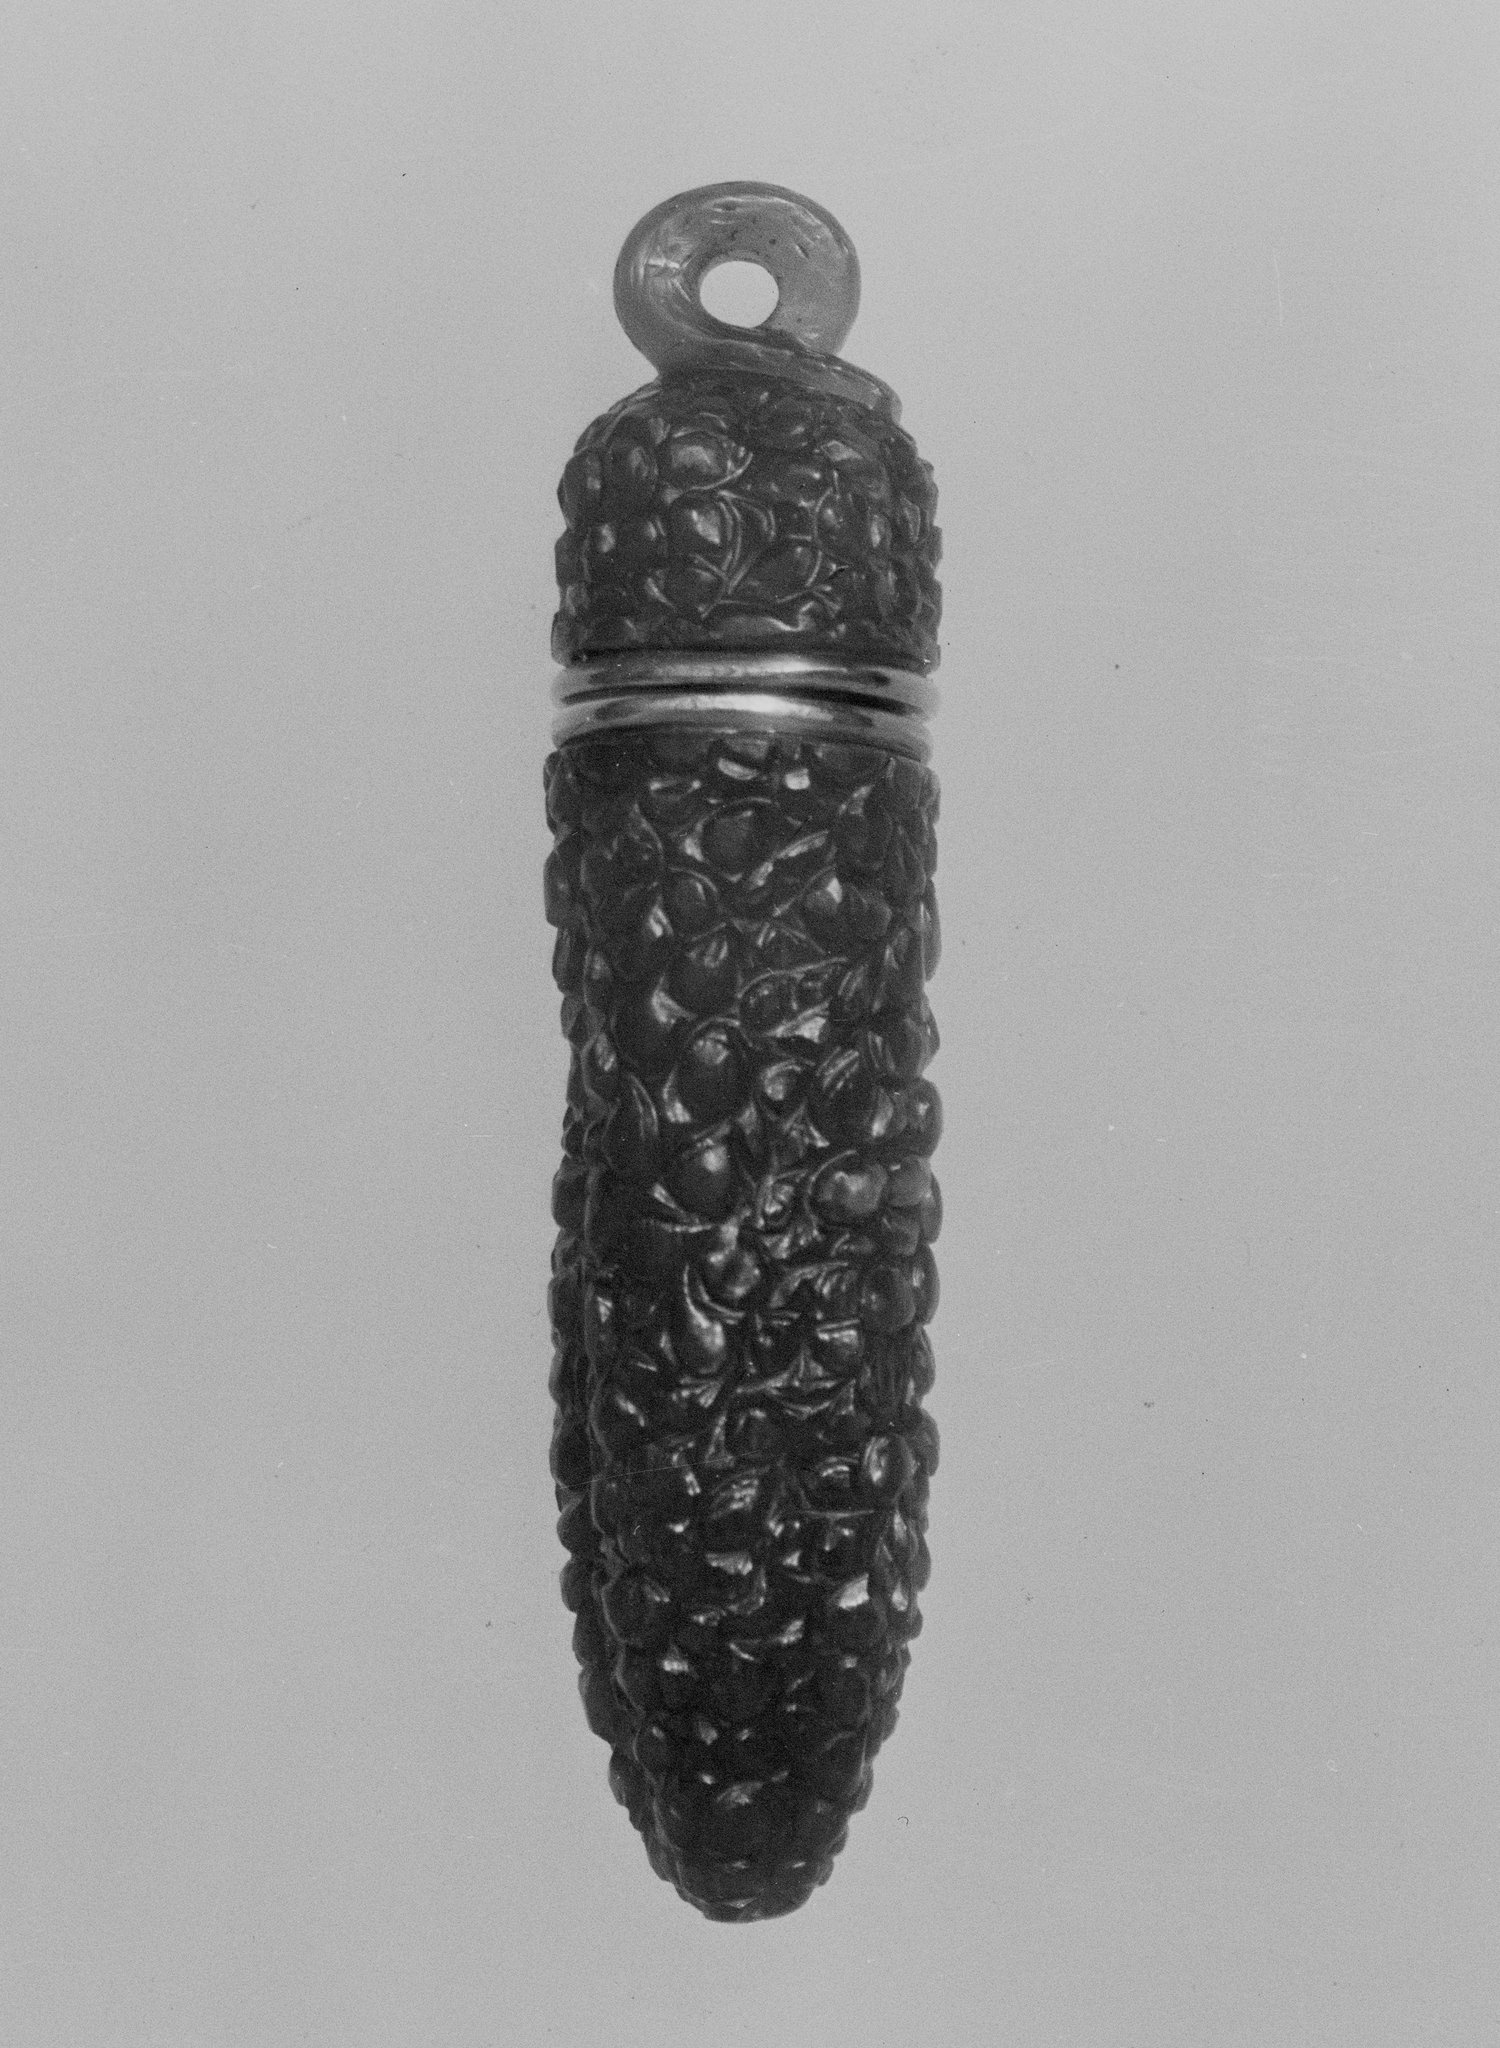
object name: scent bottle with hinged cover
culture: french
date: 1897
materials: jade